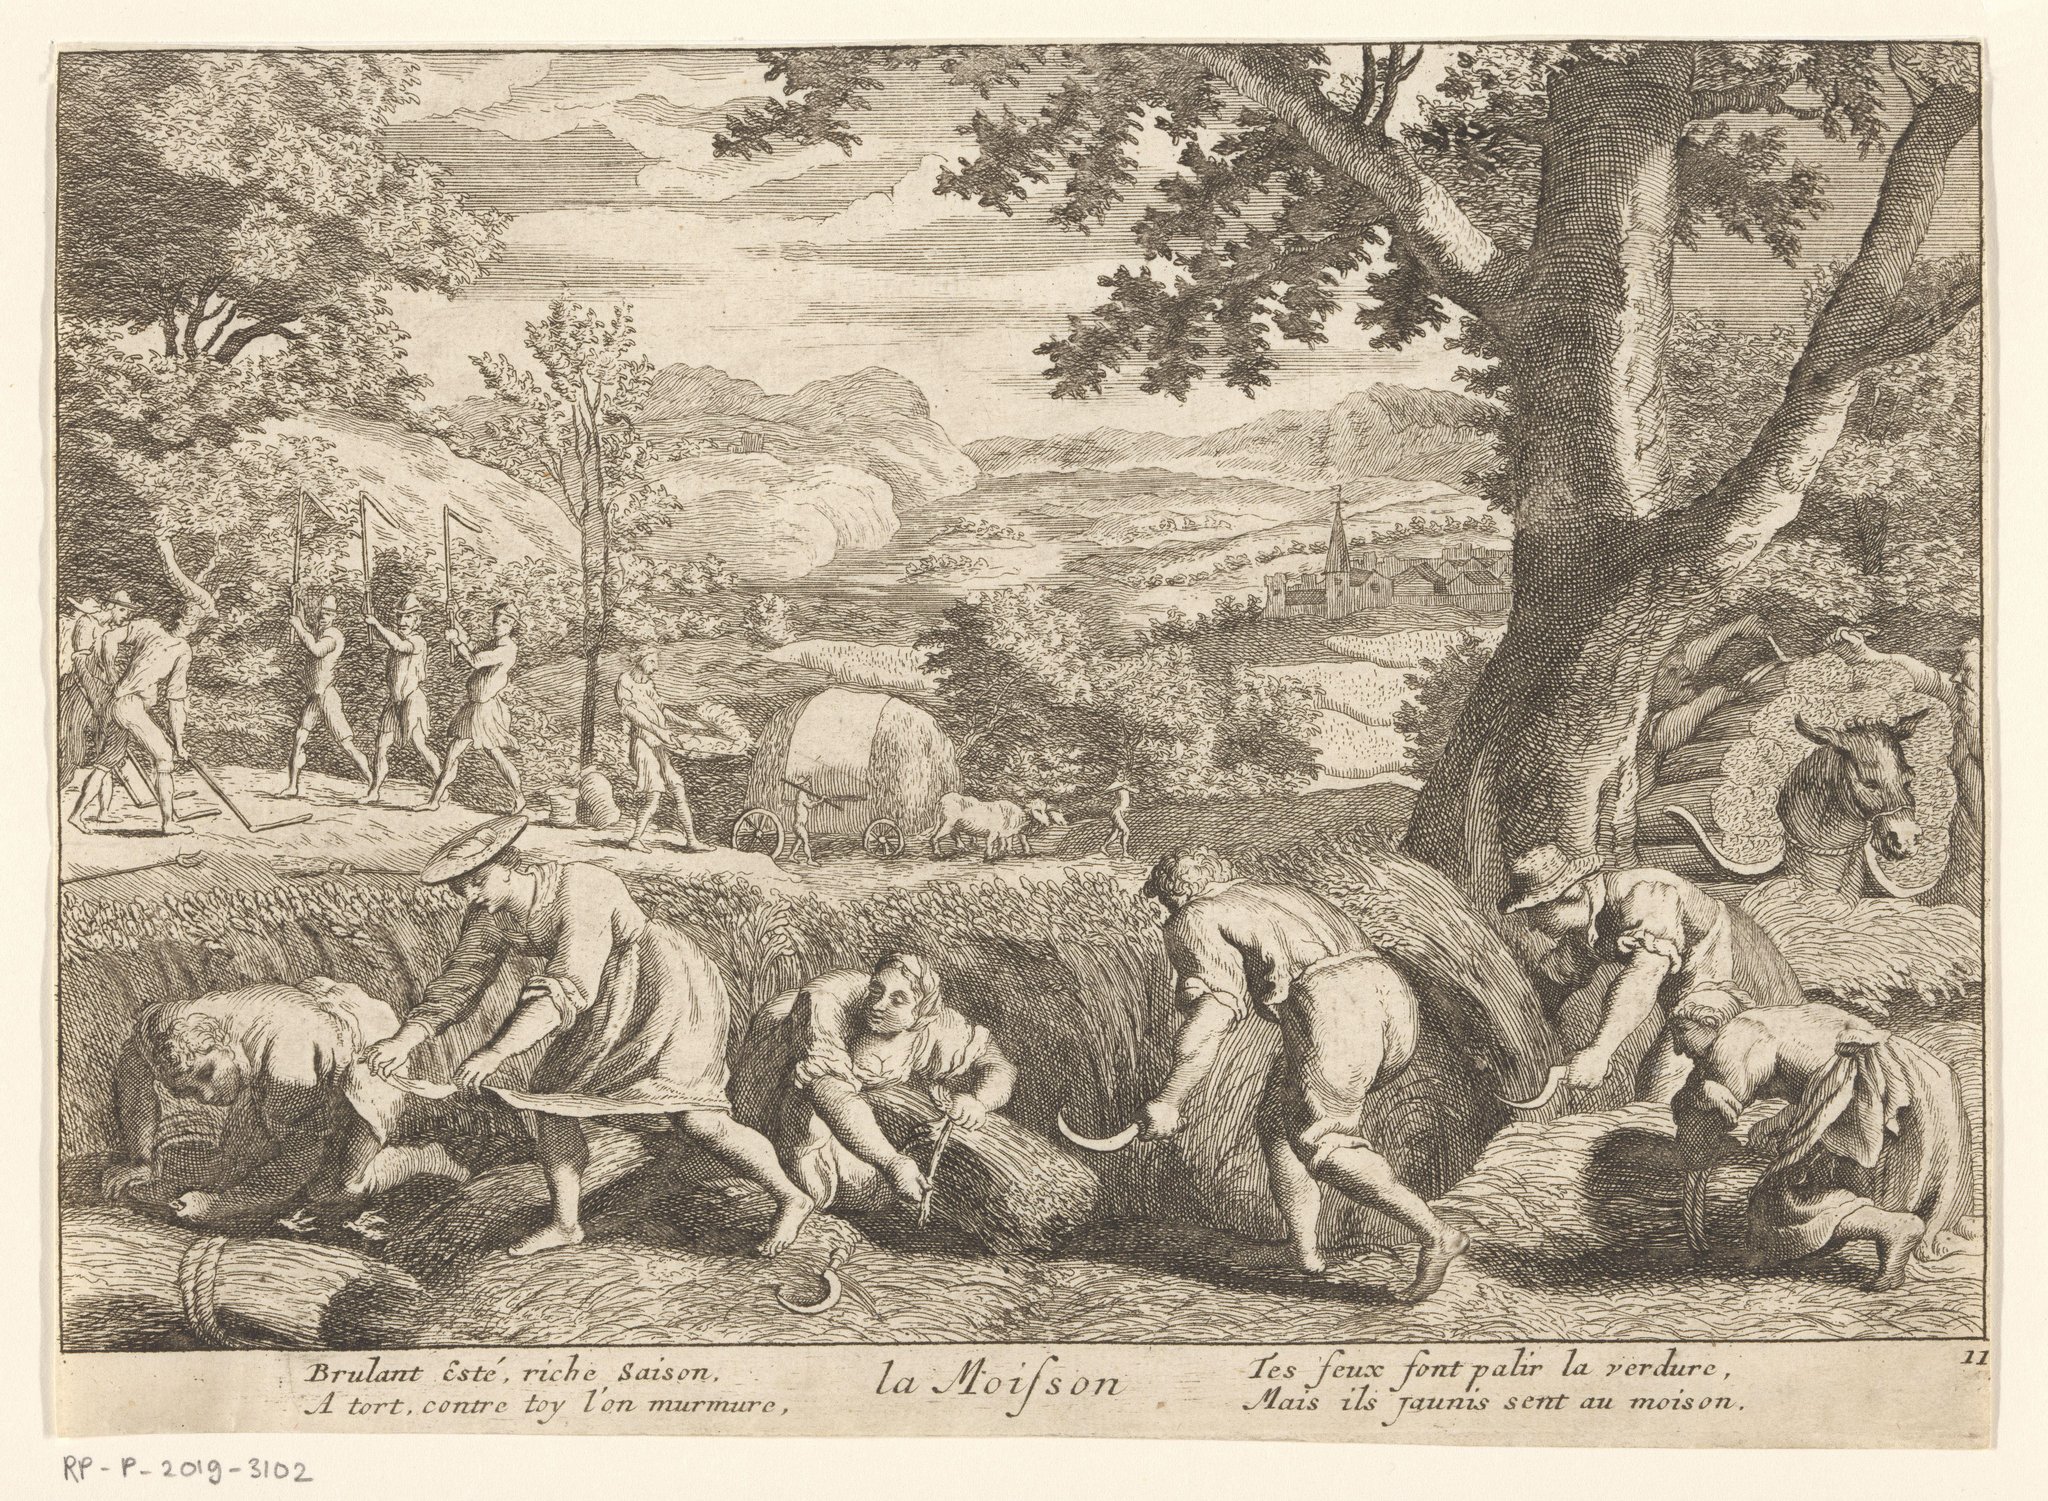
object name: print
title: Landelijke en pastorale scènes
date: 1661-1726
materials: paper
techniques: engraving, etching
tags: cereal, grain, corn (grass with grains, grown for food, e.g.: wheat, rice, rye, oats, maize, buckwheat, millet), reaping, picking, mowing ~ harvest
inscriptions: collector's mark: Lugt 2228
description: Maakt deel uit van een zestiendelige serie met landelijke en pastorale scènes, uitgegeven door Gerard Valck.